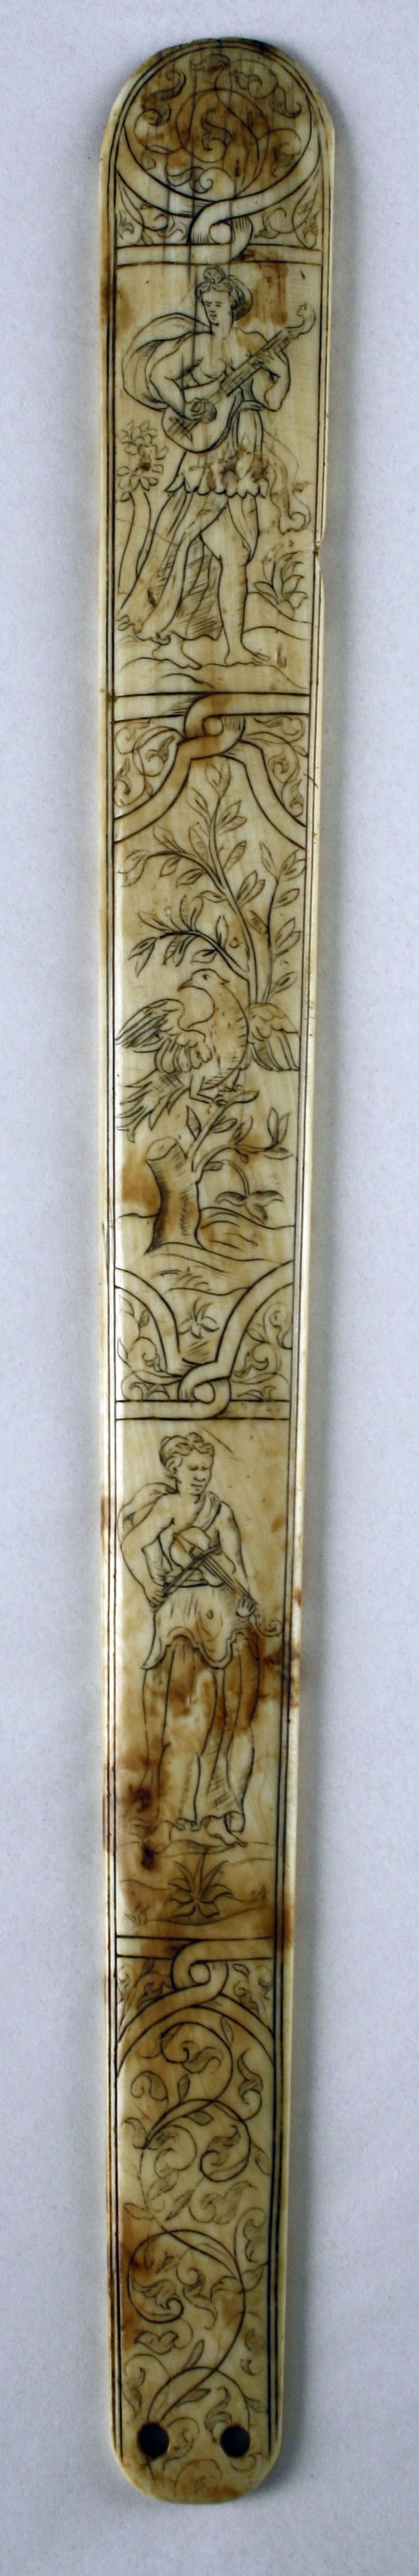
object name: busk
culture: french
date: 1601-1700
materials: ivory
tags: musical instruments,birds,women